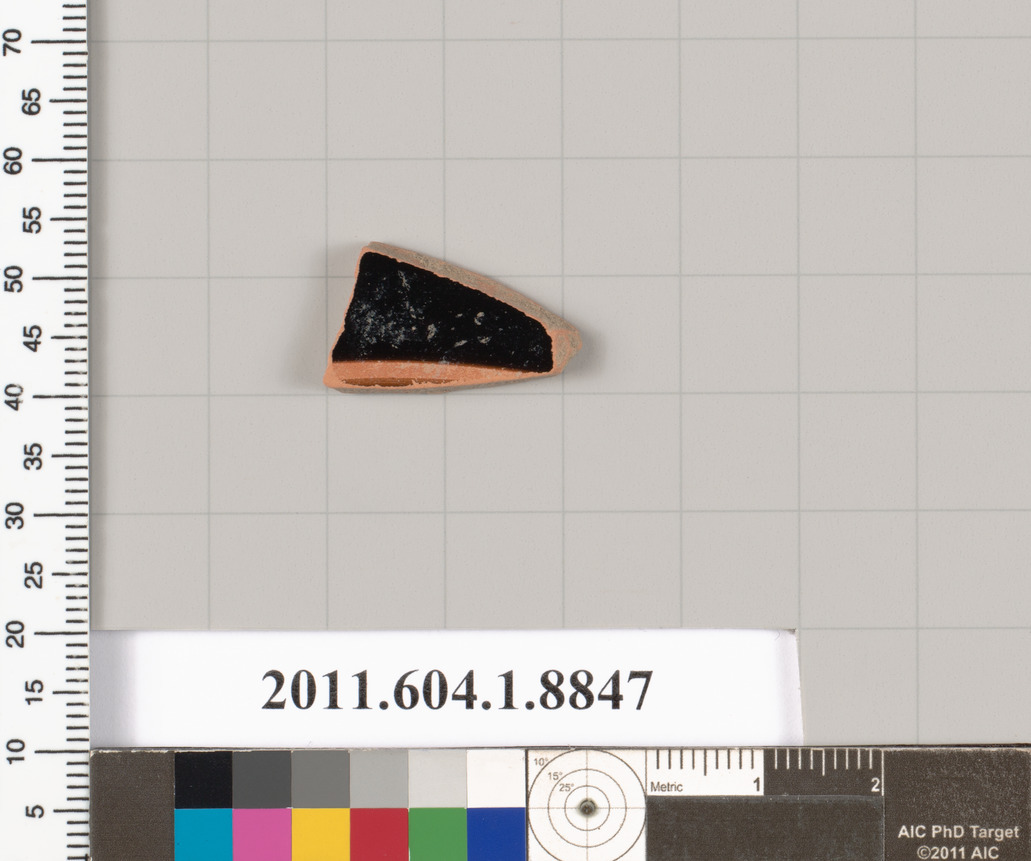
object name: kylix fragment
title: Terracotta fragment of a kylix (drinking cup)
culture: greek, attic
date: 500-470 BCE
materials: terracotta